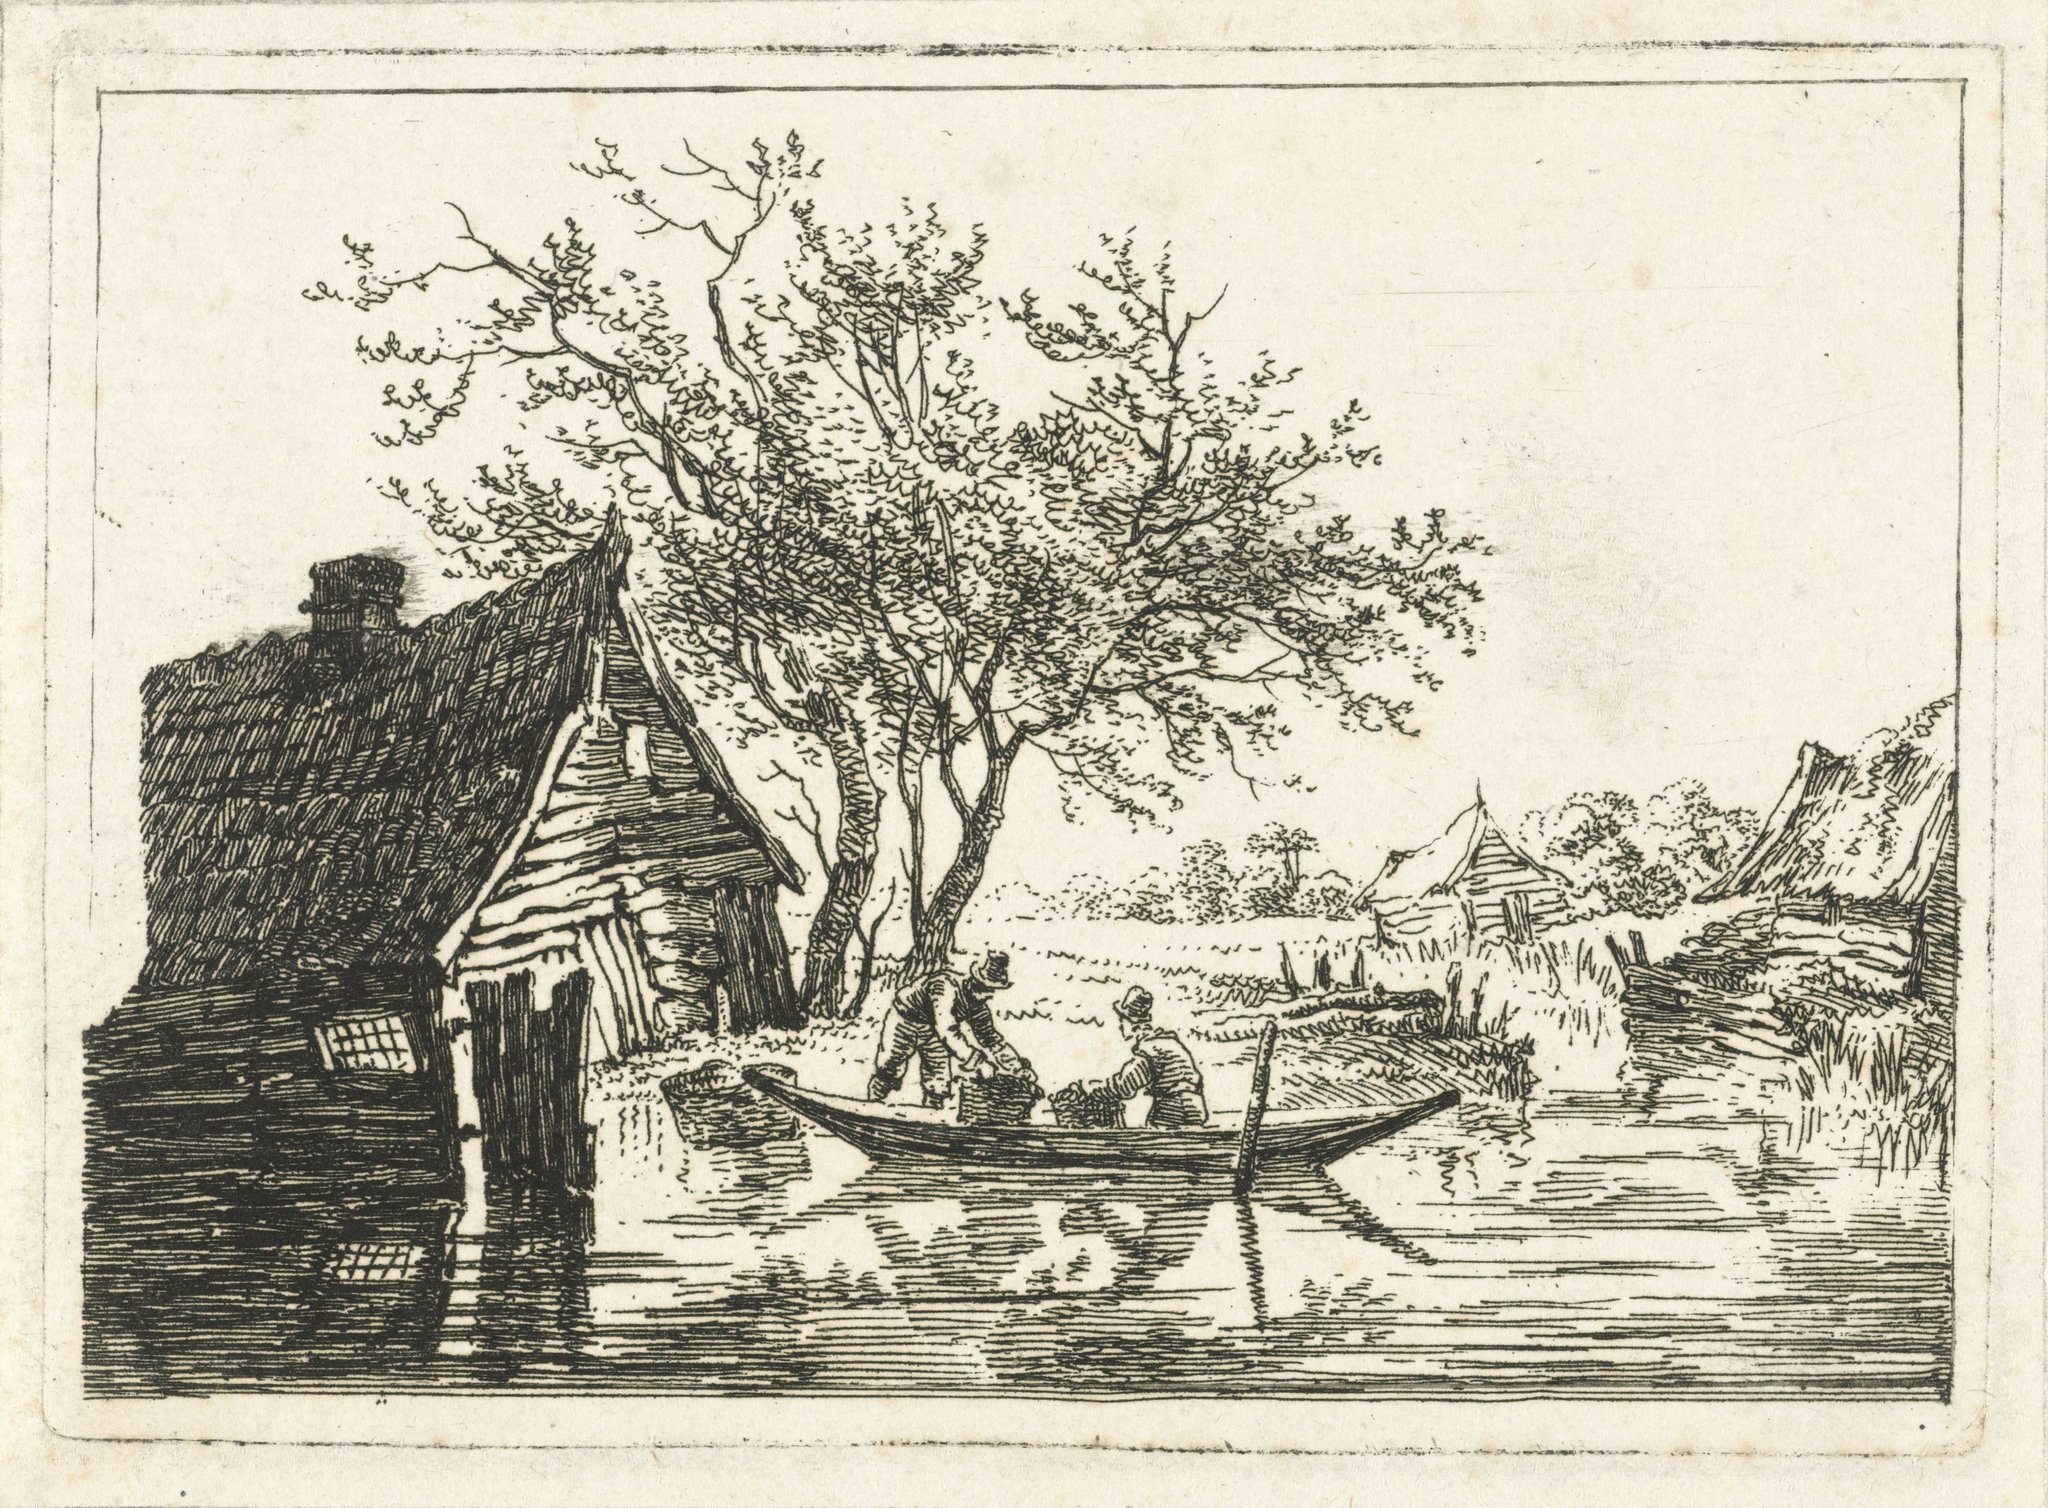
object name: print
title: Rivierlandschap met boerderij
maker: françois joseph pfeiffer (ii)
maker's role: draughtsman, print maker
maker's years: 1778-1835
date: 1793-1835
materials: paper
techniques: etching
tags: rowing-boat, canoe, etc., farm or solitary house in landscape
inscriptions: collector's mark: Lugt 2228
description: Rivierlandschap met een vervallen boerderij, die gedeeltelijk in het water staat. Op de voorgrond twee mannen, die manden uit de boot aan wal brengen.